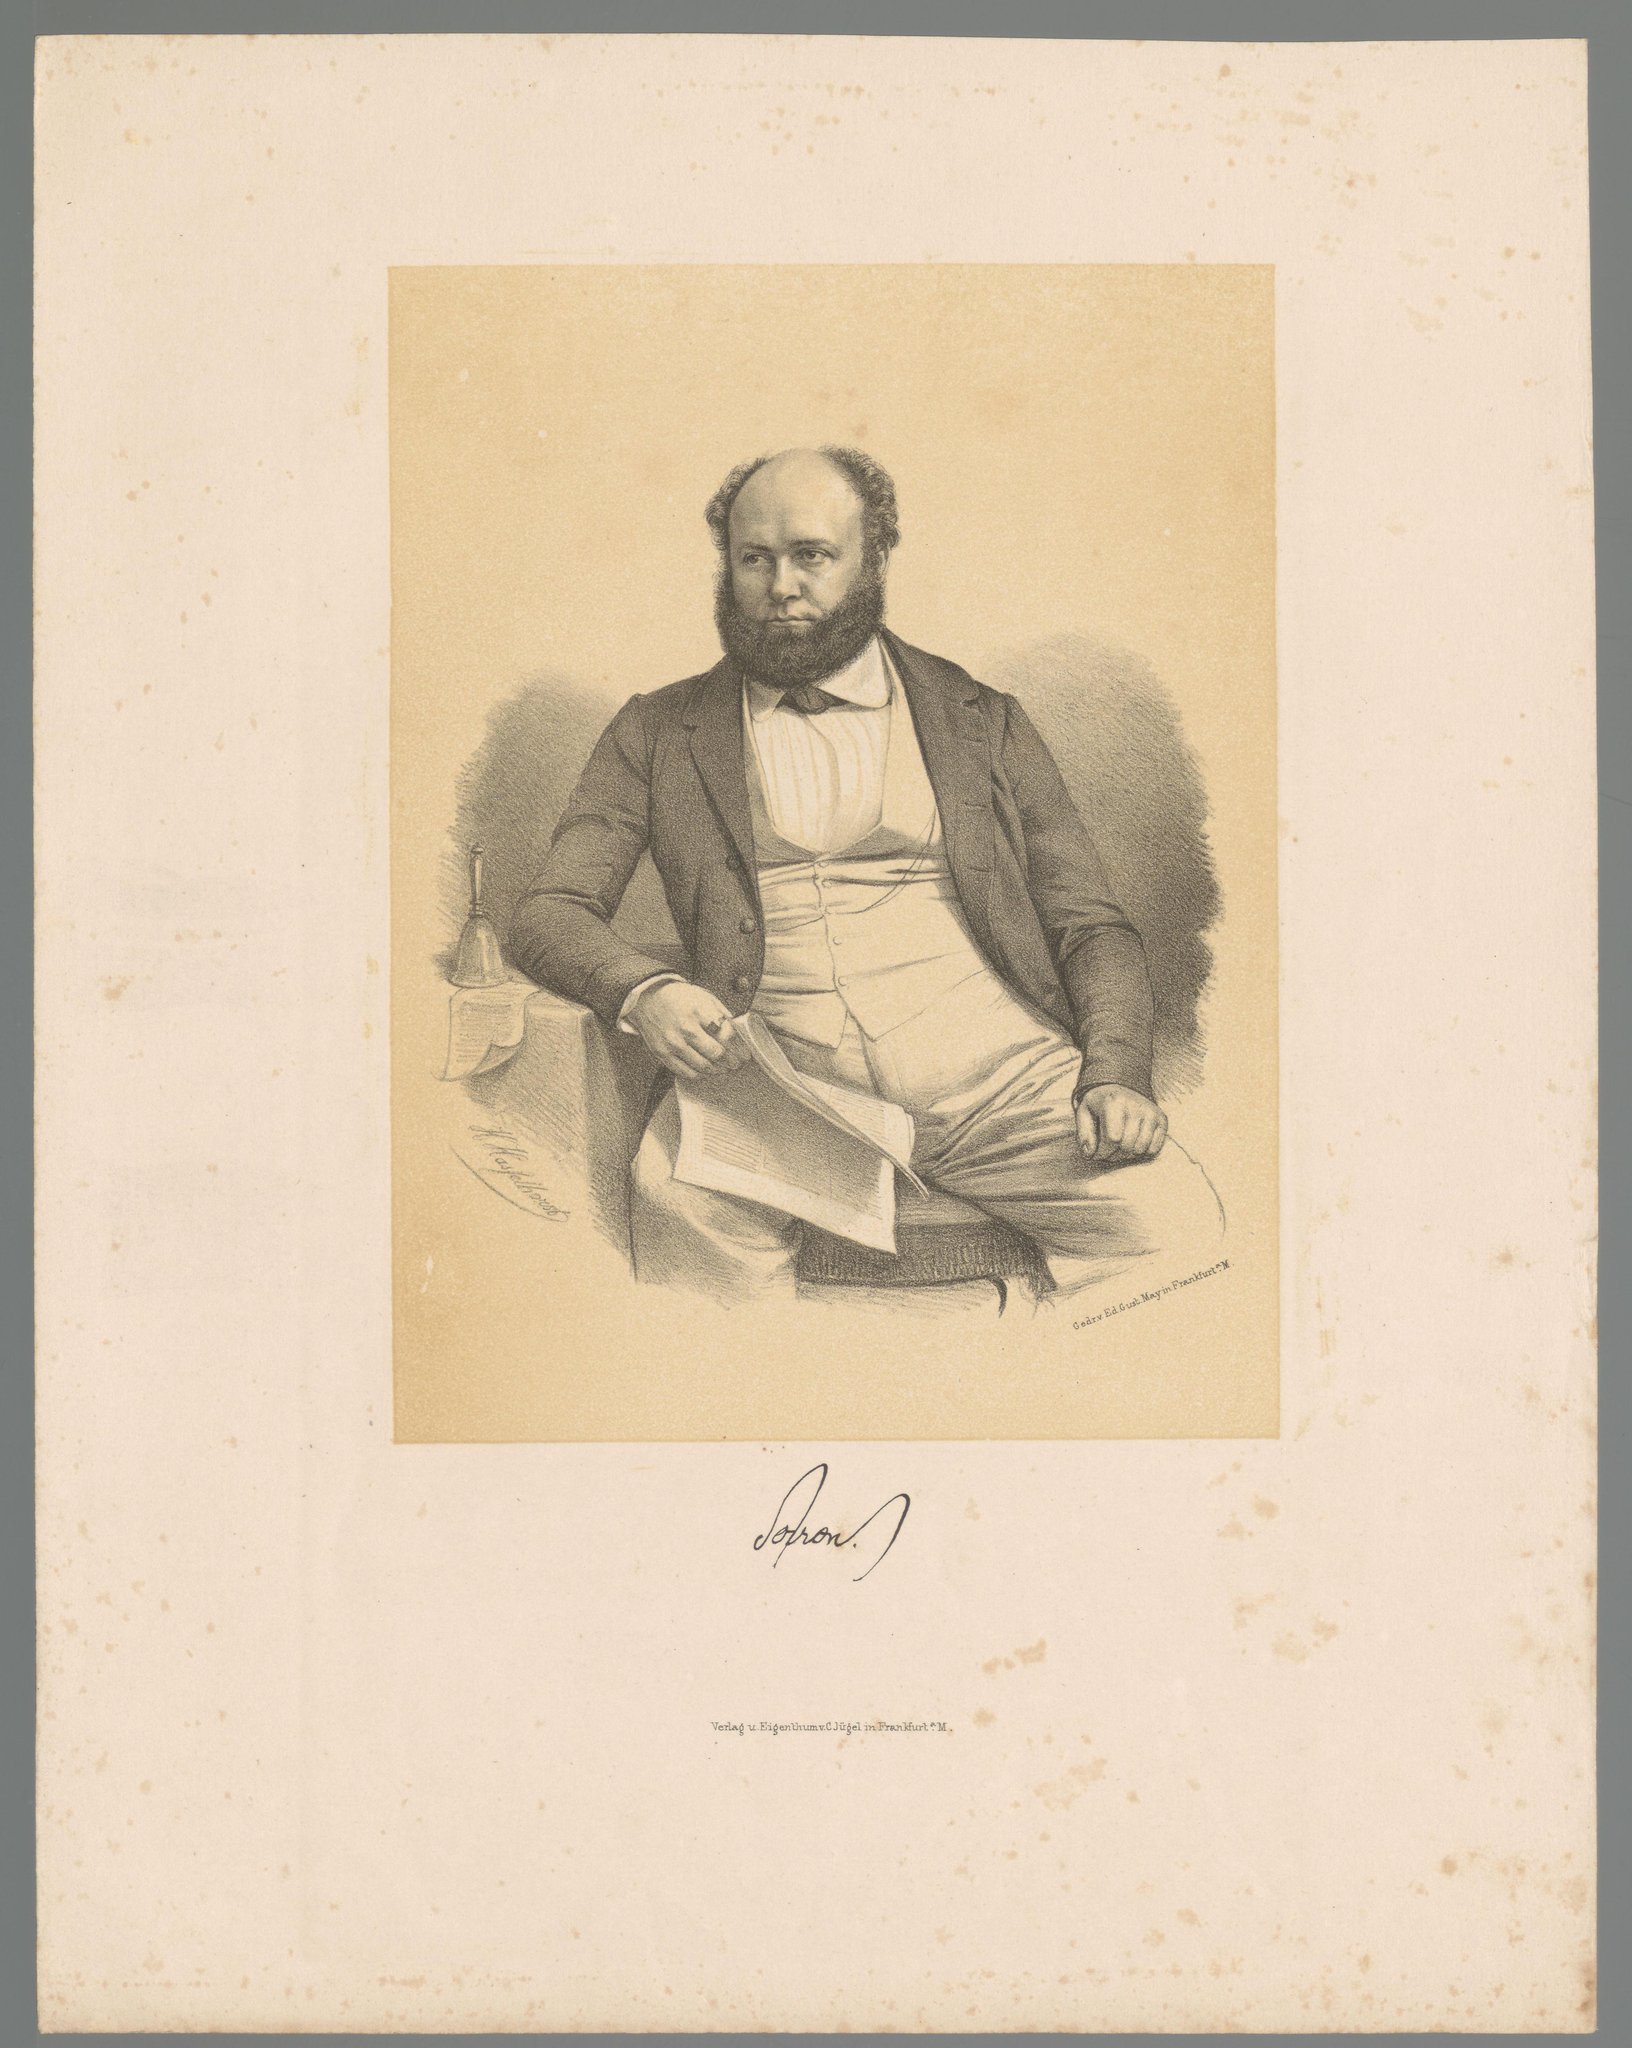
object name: print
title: Portret van Alexander von Soiron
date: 1835-1862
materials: paper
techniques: tone lithography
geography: frankfurt am main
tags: politician, historical persons, politician, e.g. party leader